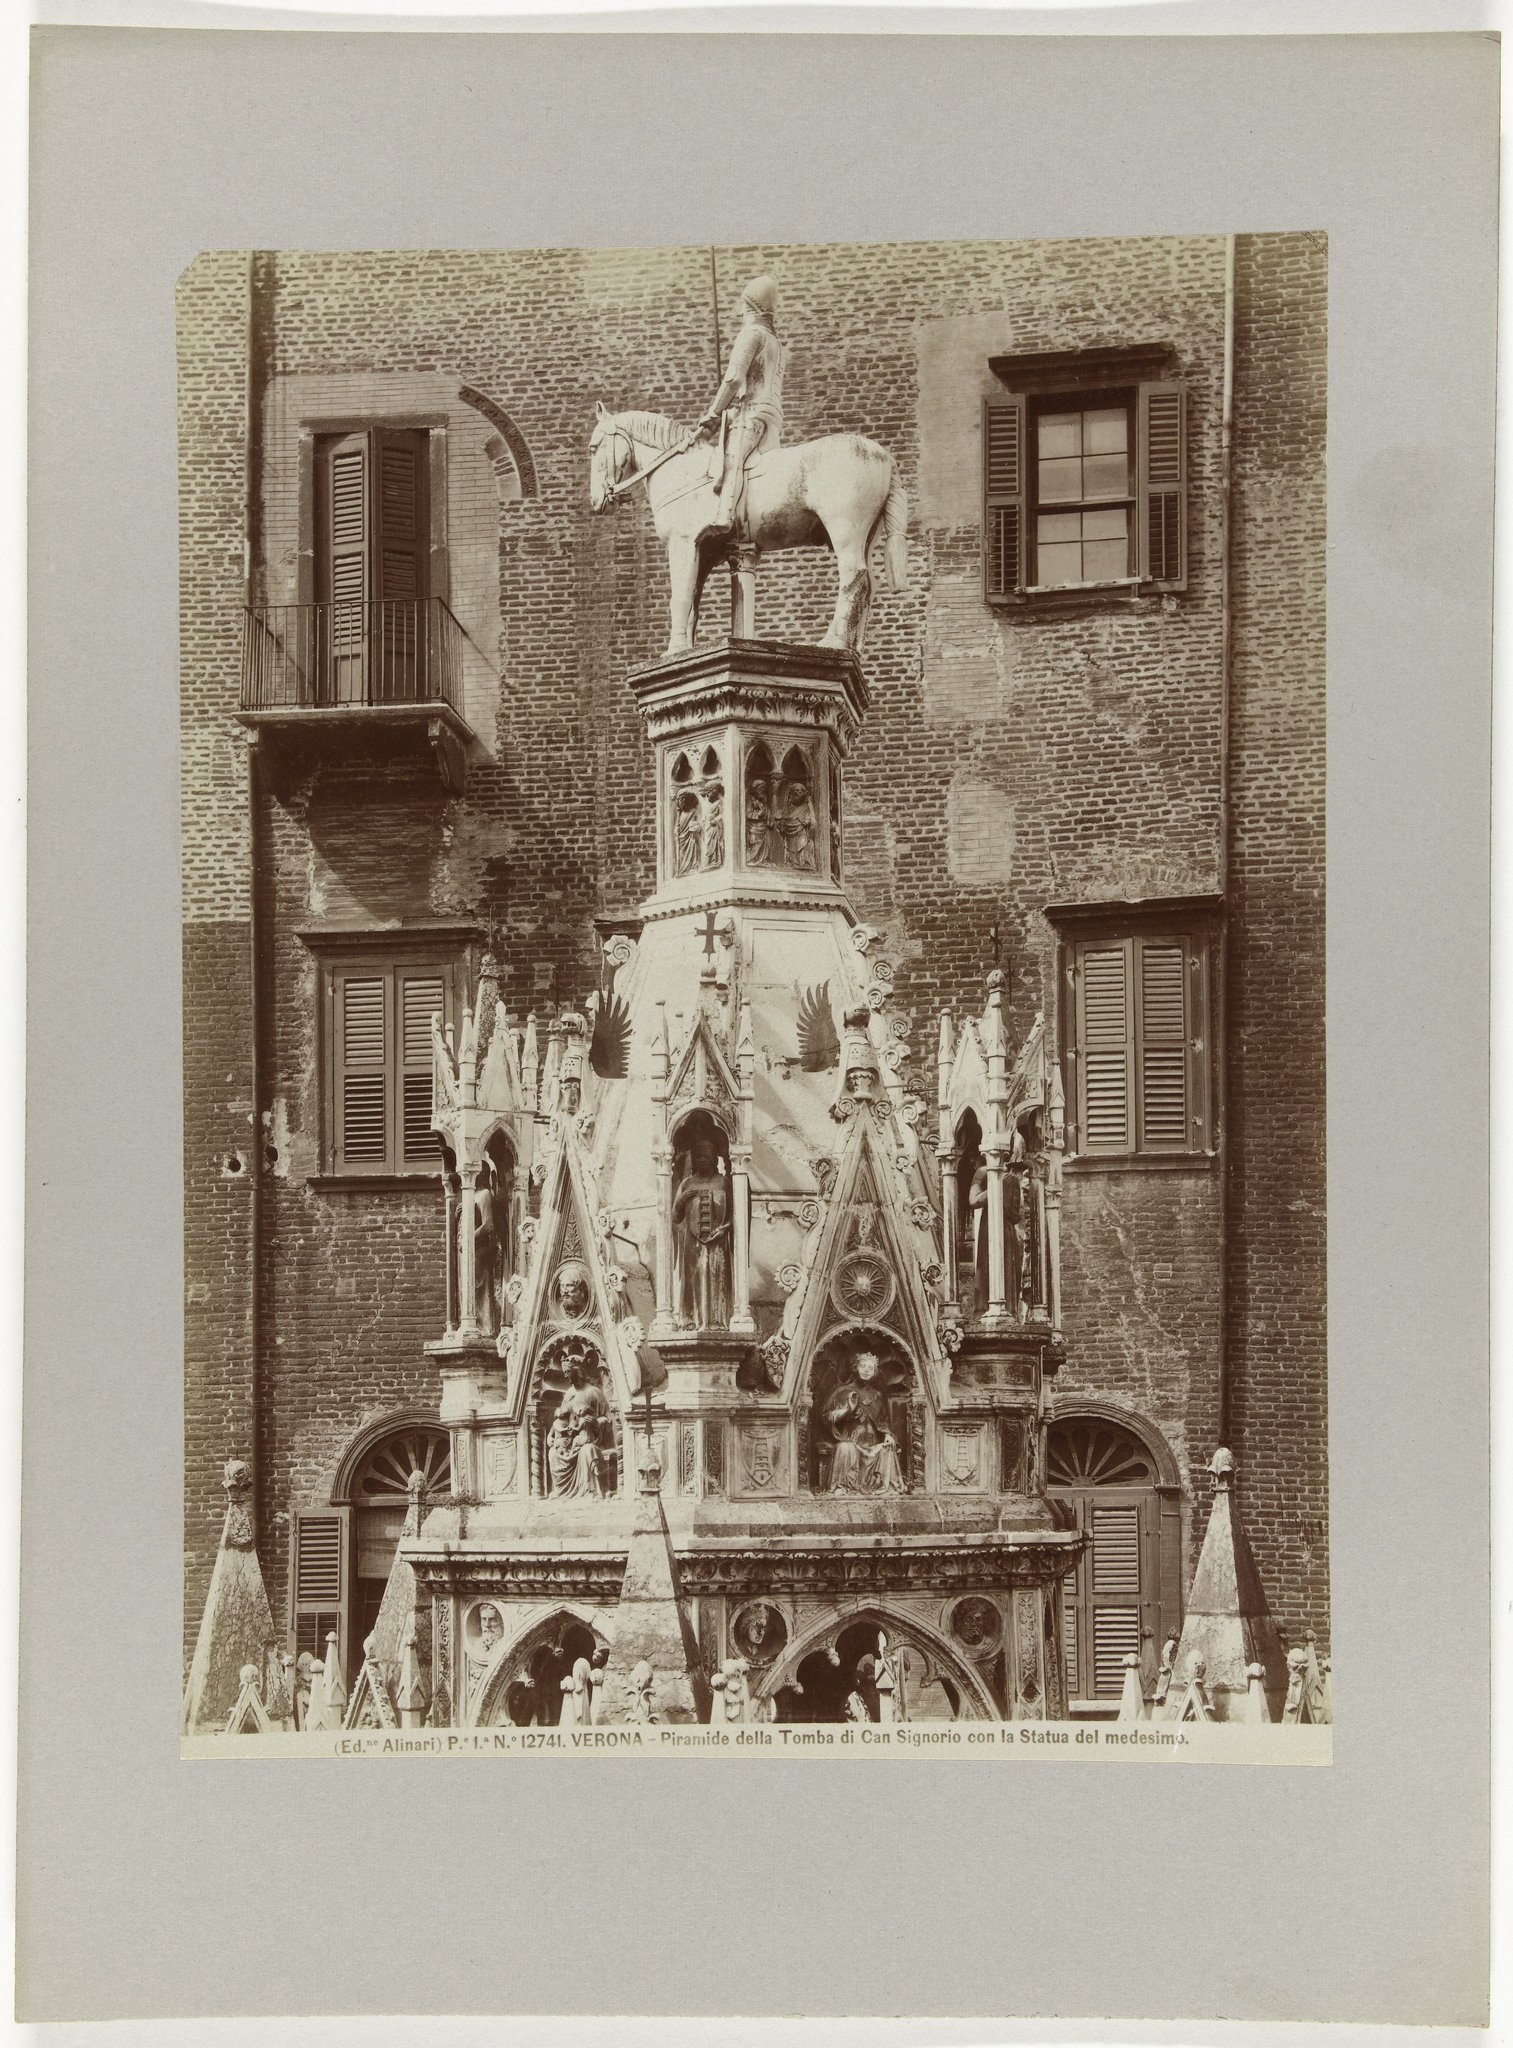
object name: photograph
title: Sculpturale bekroning van de Tomba di Can Signorio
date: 1880-1895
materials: cardboard, paper, photographic support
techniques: albumen print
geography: florence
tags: piece of sculpture, reproduction of a piece of sculpture, grave-building, monumental tomb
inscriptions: number: ‘94.’